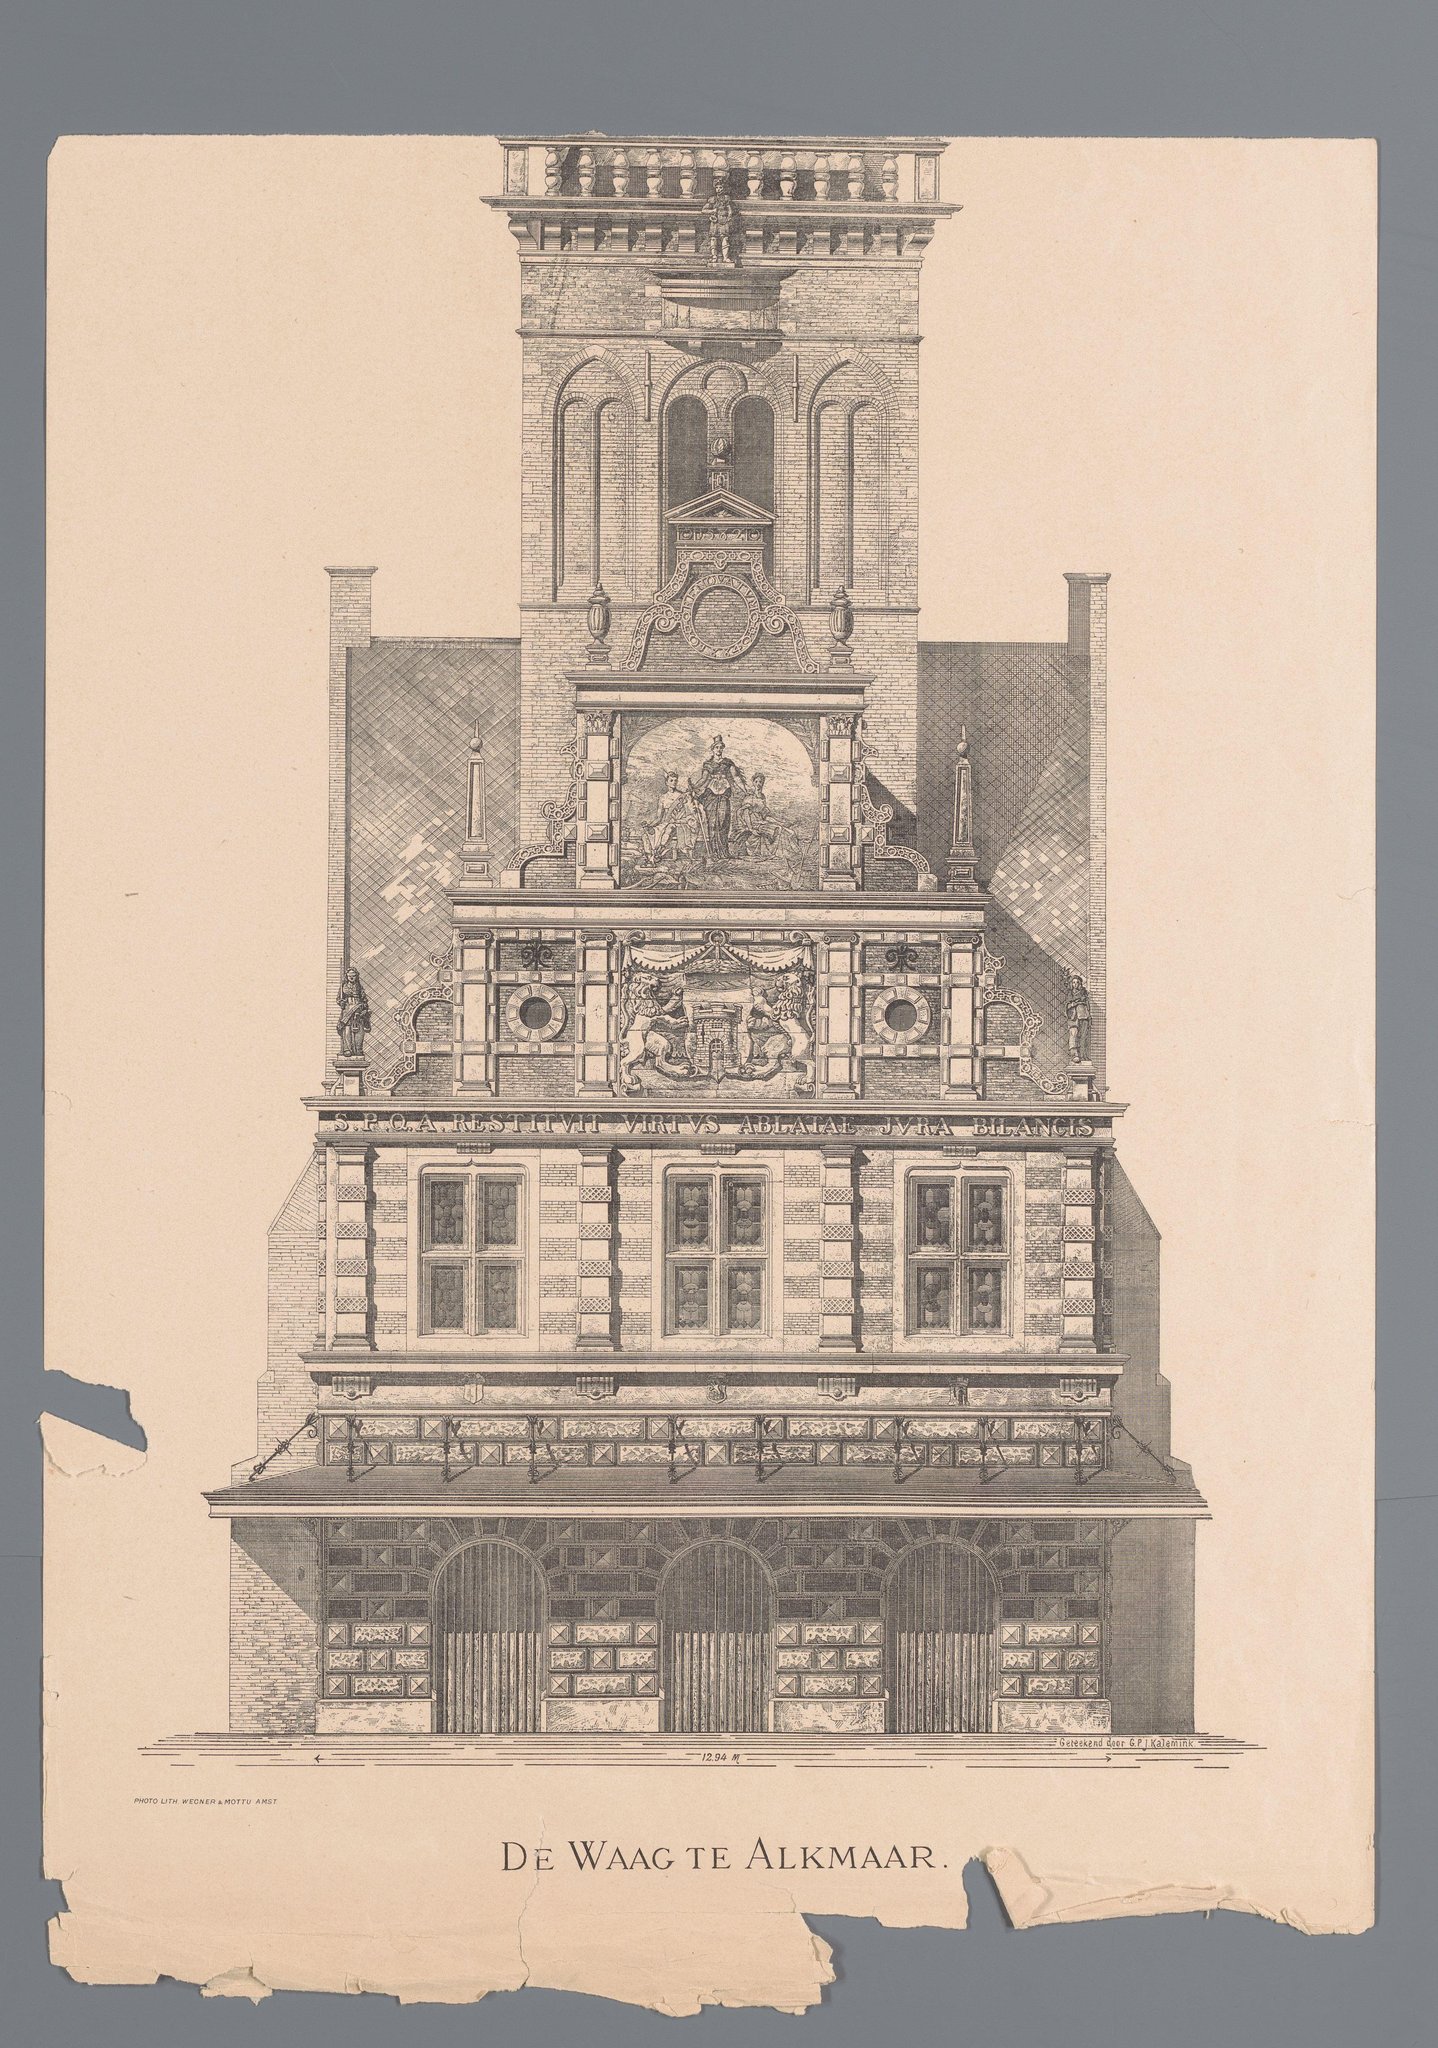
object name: print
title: Bovenste deel van een gezicht op de Waag, te Alkmaar, bestaande uit twee delen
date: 1885-1900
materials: paper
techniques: photolithography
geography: amsterdam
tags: weigh-house